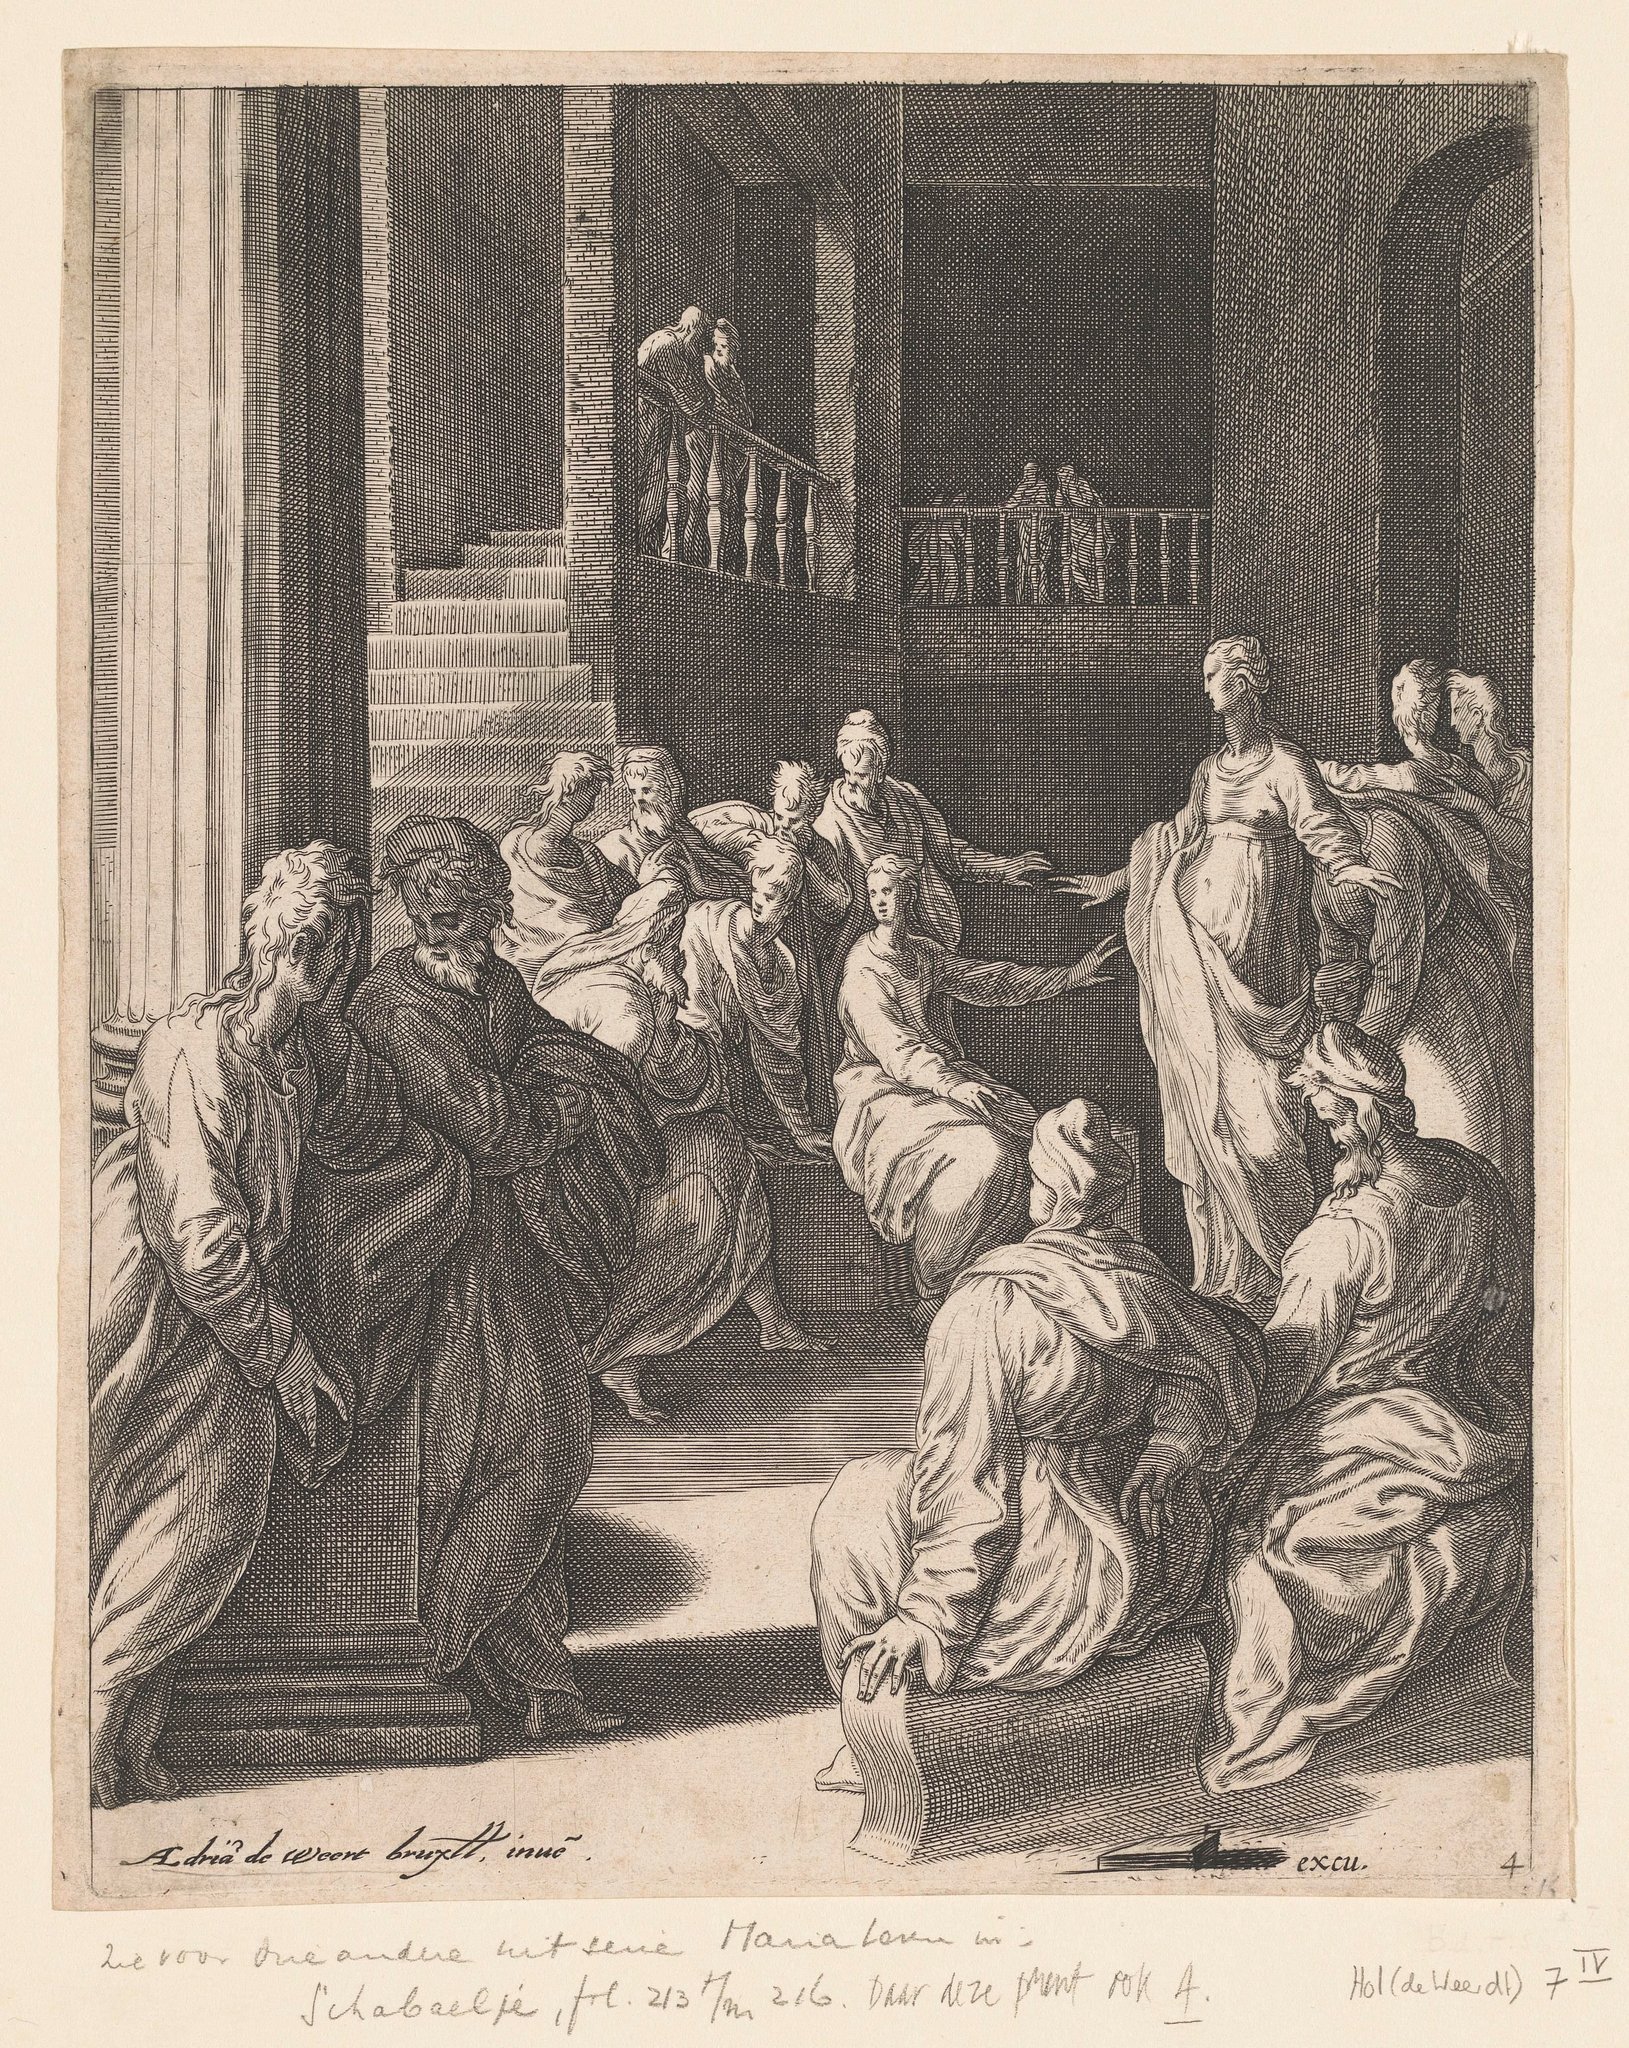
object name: print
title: Christ among the Doctors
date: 1550-1599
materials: paper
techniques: engraving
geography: brussels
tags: christ's dispute with the doctors in the temple; he counts his arguments on his fingers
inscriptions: collector's mark: Lugt 2228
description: The drawings by De Weerdt (on the adjacent wall) were transformed into engravings by Isaac Duchemin, a Netherlandish-born printmaker who, like De Weerdt, had settled in Cologne. The skilled engraver followed the designs extremely closely, translating De Weerdt’s painterly compositions into a dense network of lines, crosshatches, and dots. As a result of the printmaking process, the compositions appear in reverse.